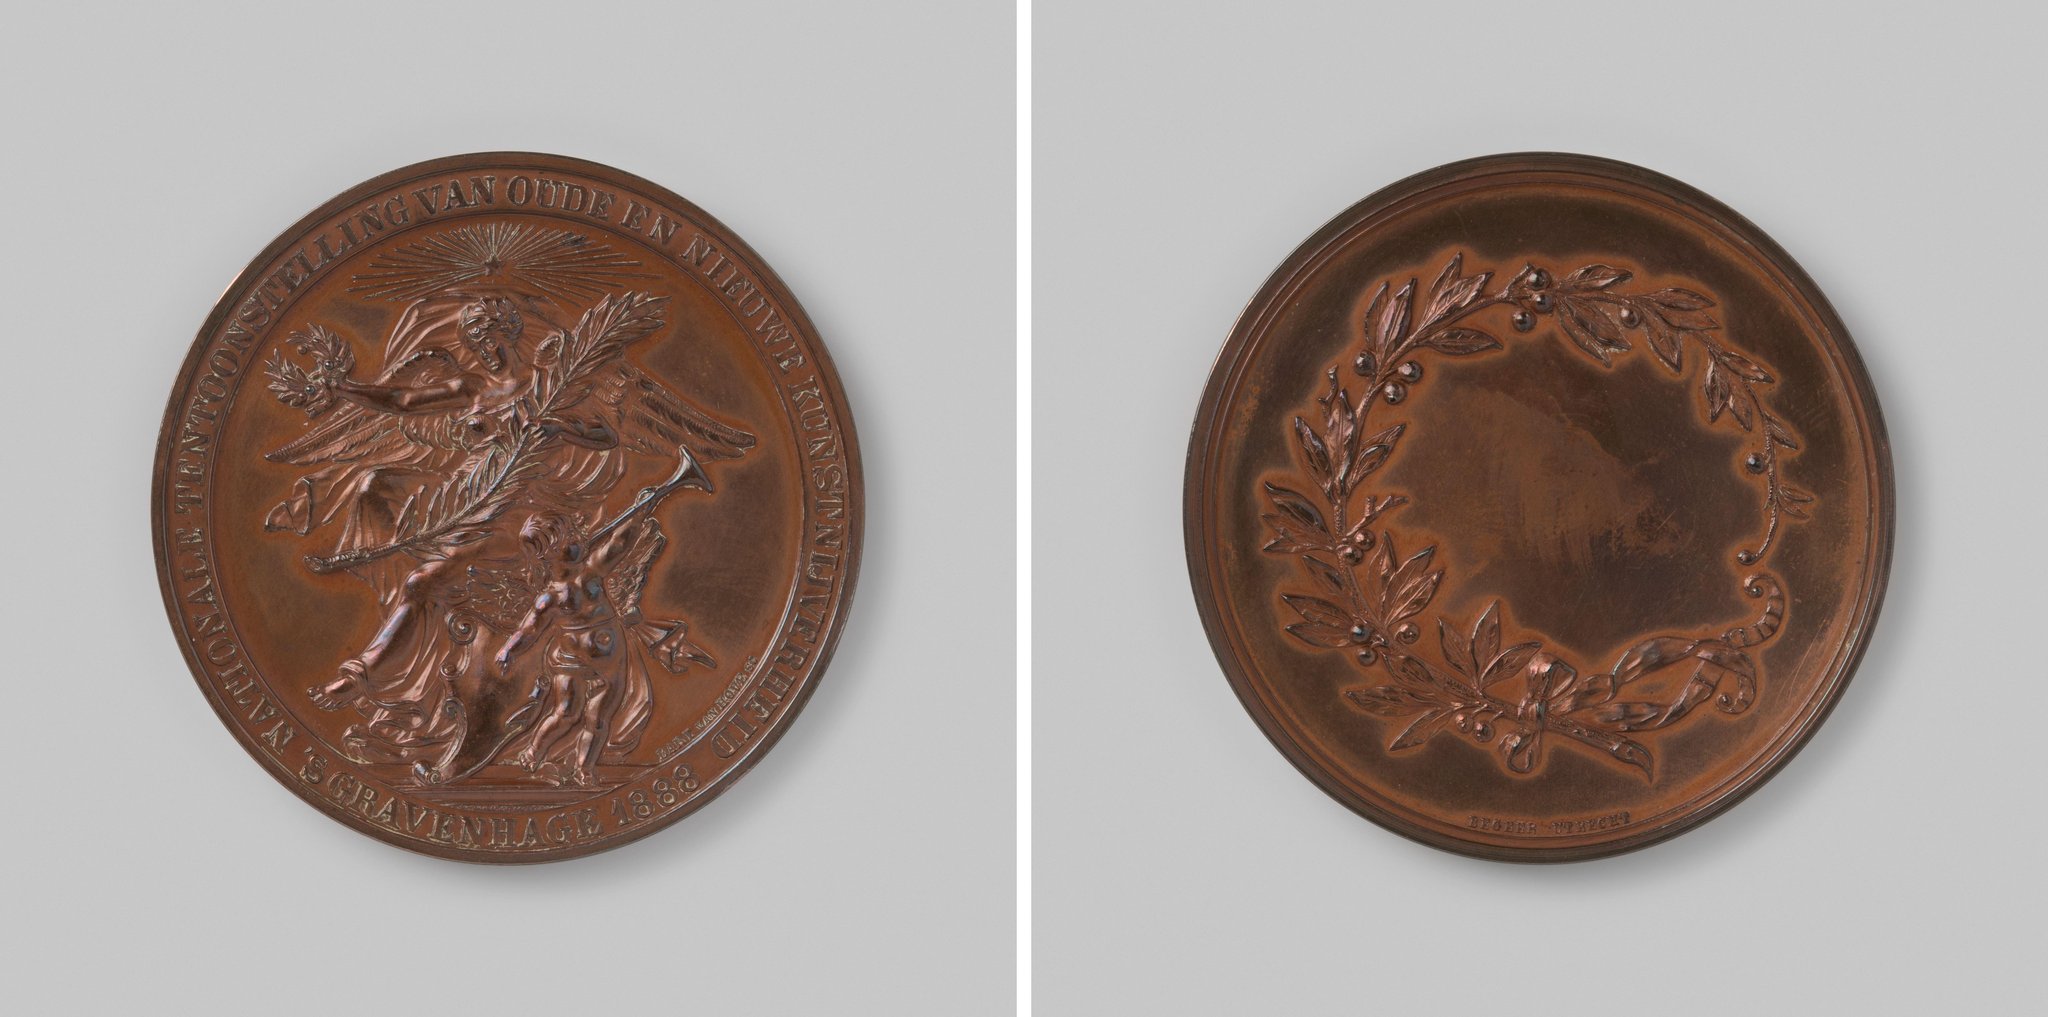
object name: medal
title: Nationale tentoonstelling van oude en nieuwe kunstnijverheid, 's Gravenhage 1888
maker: bart van hove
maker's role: sculptor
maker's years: 1850-1914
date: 1888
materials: bronze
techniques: striking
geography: netherlands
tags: the hague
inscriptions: signature: ‘BART VAN HOVE SC’, signature: ‘BEGEER UTRECHT’, circumscription: ‘NATIONALE TENTOONSTELLING VAN OUDE EN NIEUWE KUNSTNIJVERHEID 'S GRAVENHAGE 1888’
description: Bronzen penning. Voorzijde: zittende engel met lauwertak en krans. Aan haar voeten een schild en een putto blazend op een bazuin. Boven haar hoofd een stralende ster; met omschrift en signatuur. Keerzijde: krans en signatuur.